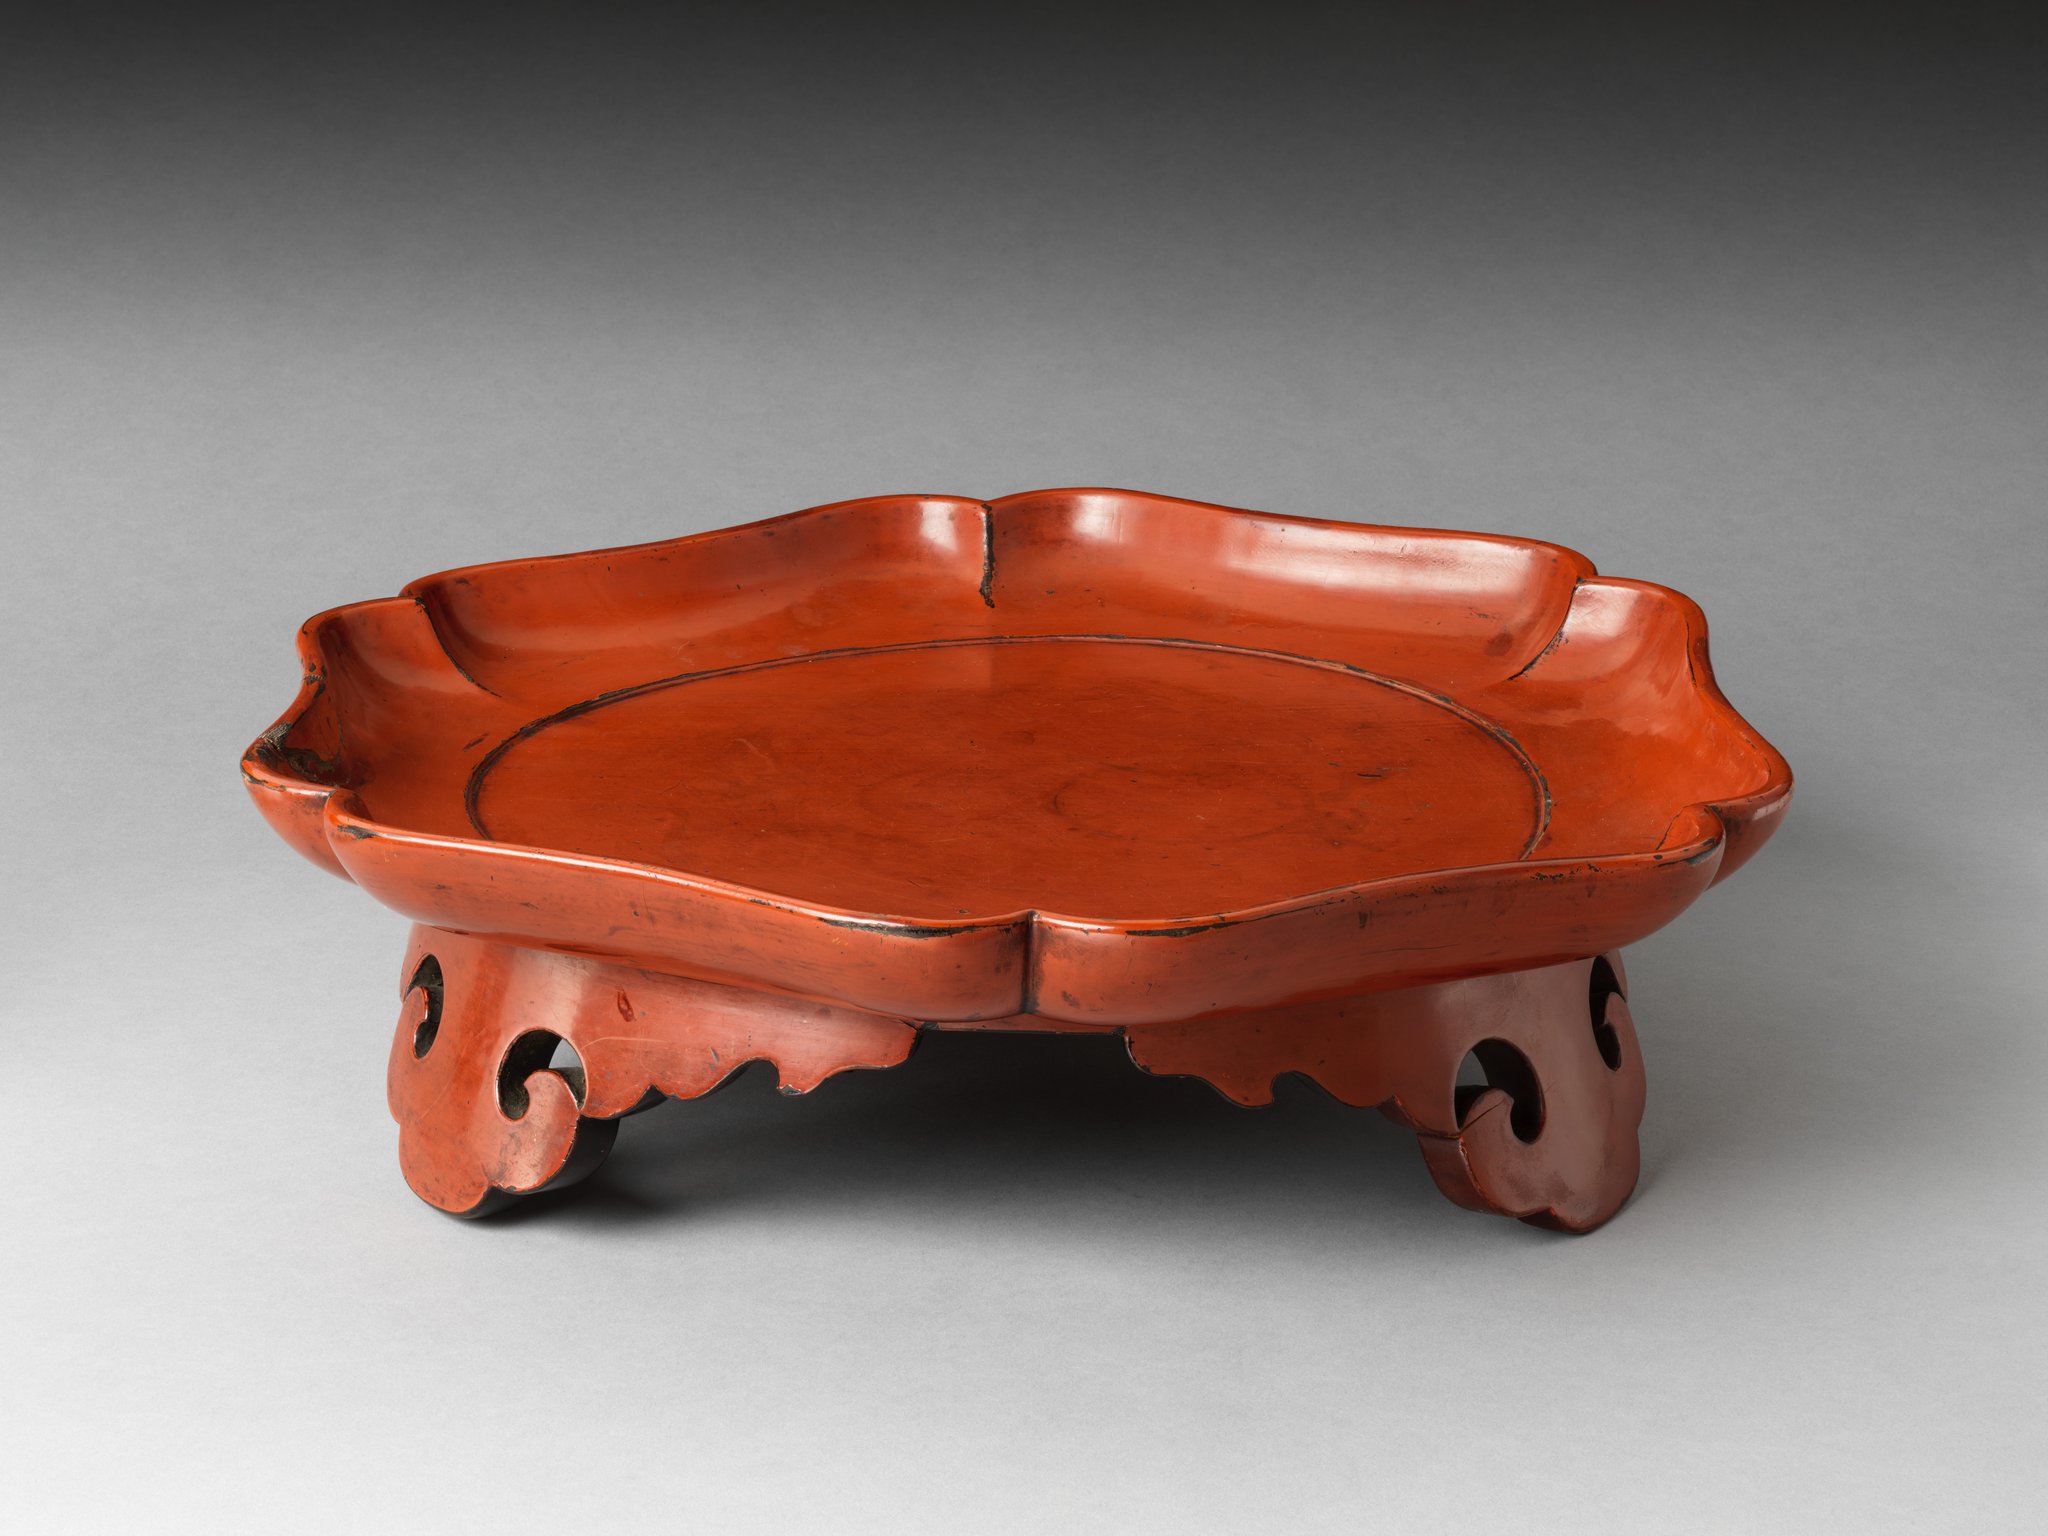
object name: tray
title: Round Negoro Tray (Ashitsuki-ban) with Three Feet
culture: japanese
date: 1401-1600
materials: lacquer, wood